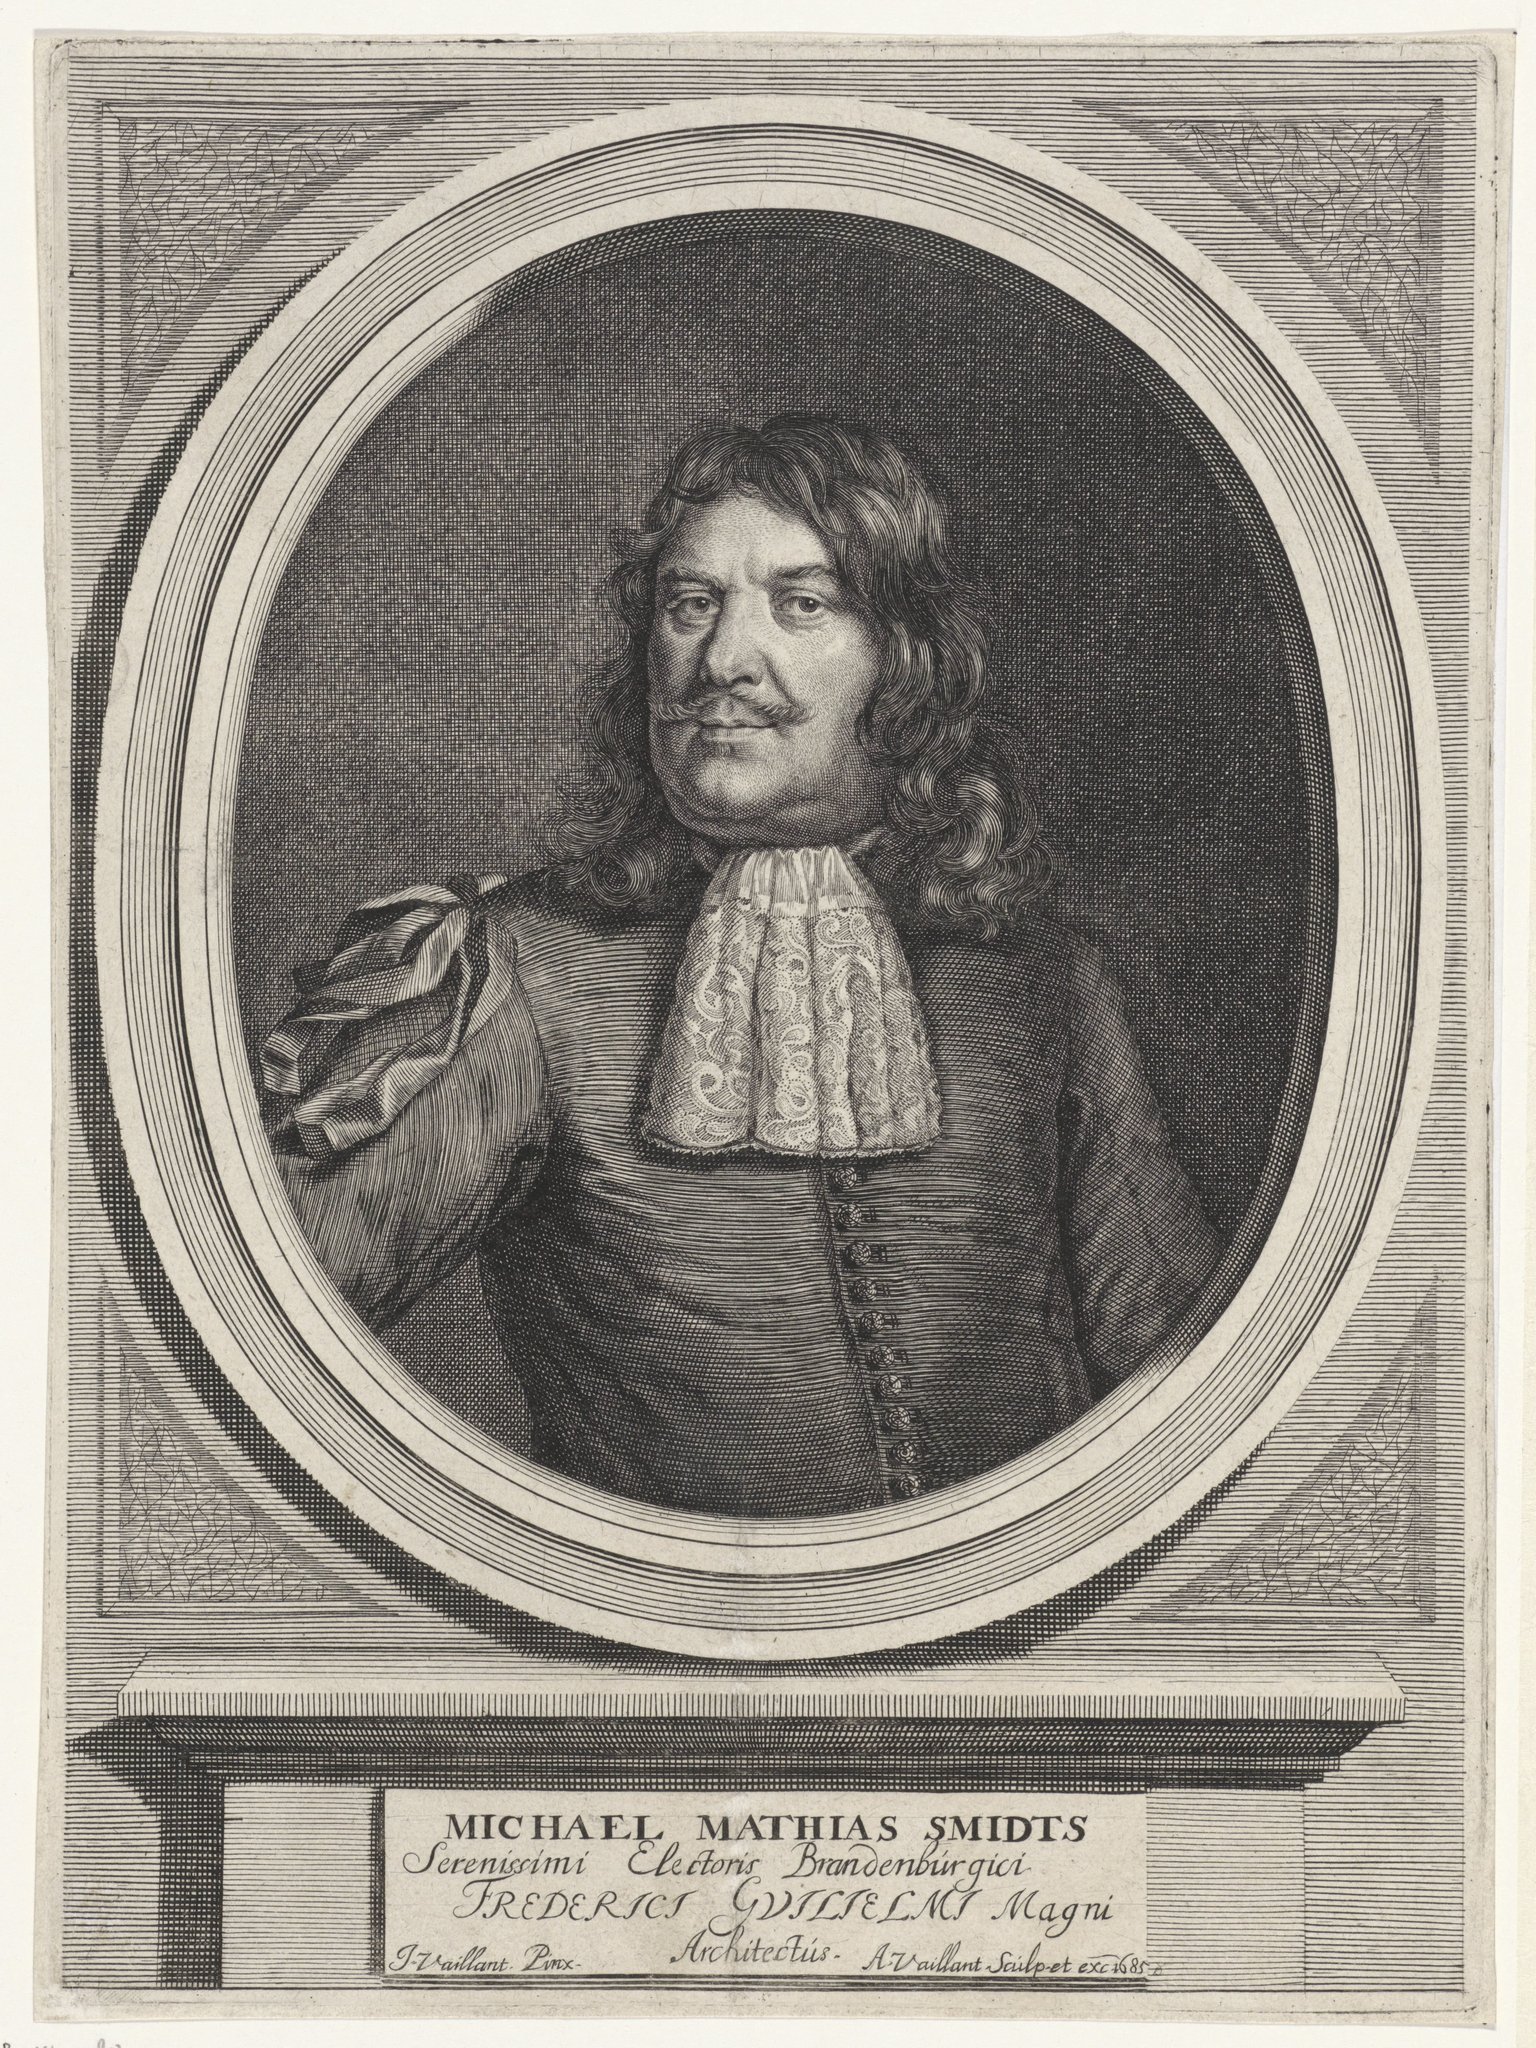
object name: print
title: Portret van Michael Mathias Smidts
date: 1685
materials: paper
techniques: engraving, etching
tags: berlin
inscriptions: collector's mark: Lugt 2760, collector's mark: Lugt 2228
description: Portret van de Berlijnse architect Michael Mathias Smidts.